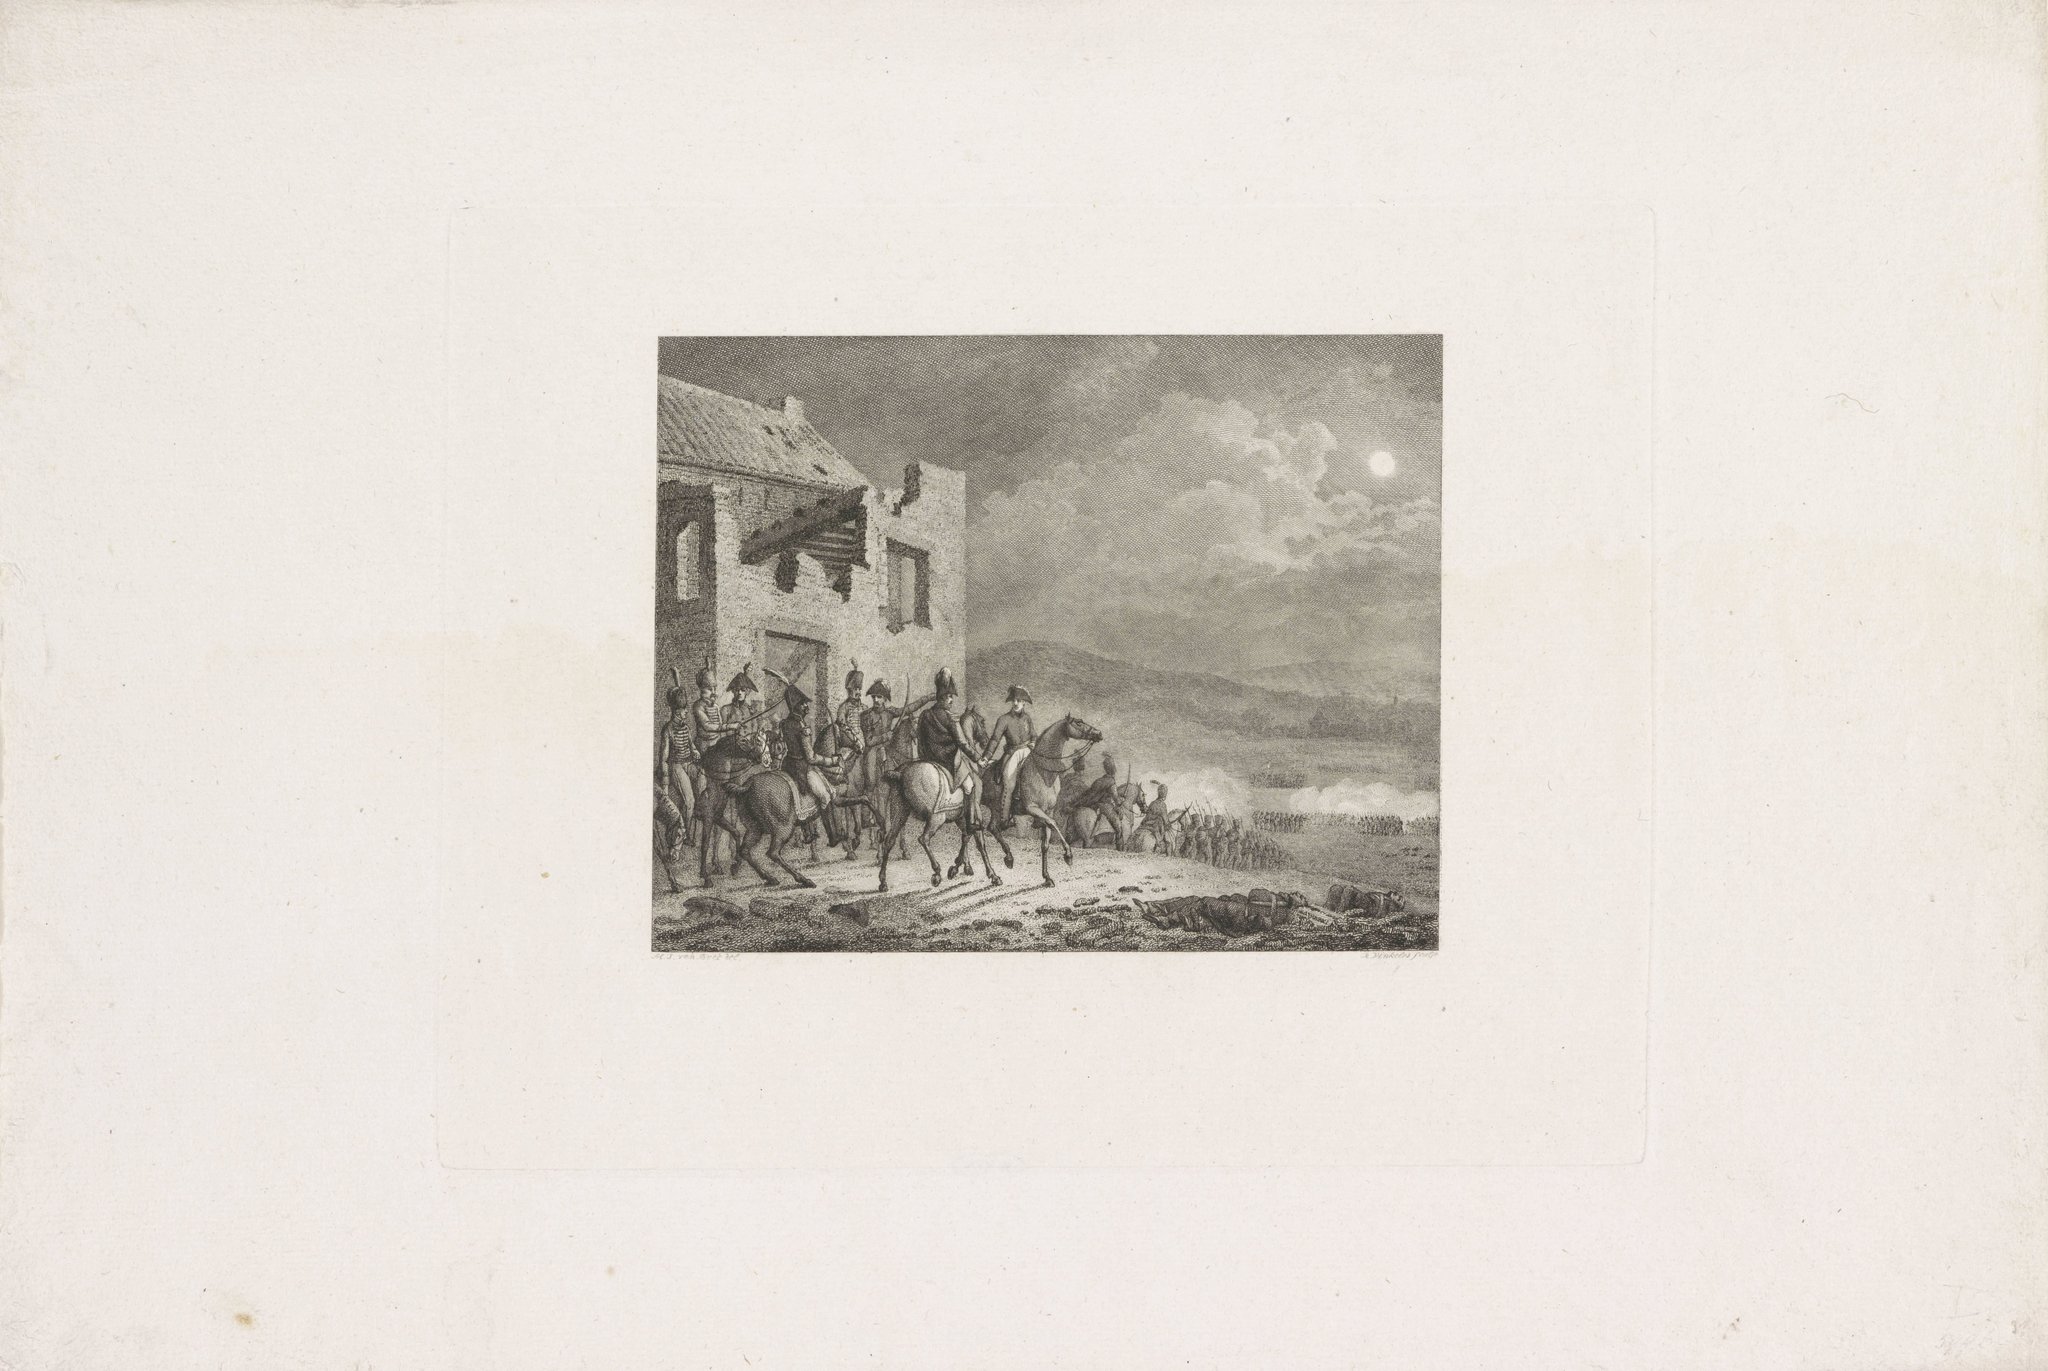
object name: print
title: Ontmoeting tussen Wellington en Blücher na de slag bij Waterloo, 1815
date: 1815-1816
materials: paper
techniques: engraving, etching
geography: netherlands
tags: walmer castle, arthur wellesley of wellington, victor (after the battle), waterloo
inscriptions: collector's mark: Lugt 2228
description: Nachtelijke ontmoeting tussen de generaals Wellington en Blücher bij de hoeve La Belle Alliance na de gewonnen slag bij Waterloo op 18 juni 1815. Onderdeel van een groep illustraties van gebeurtenissen rond en tijdens de veldslagen bij Quatre-Bras en Waterloo, 16-18 juni 1815.